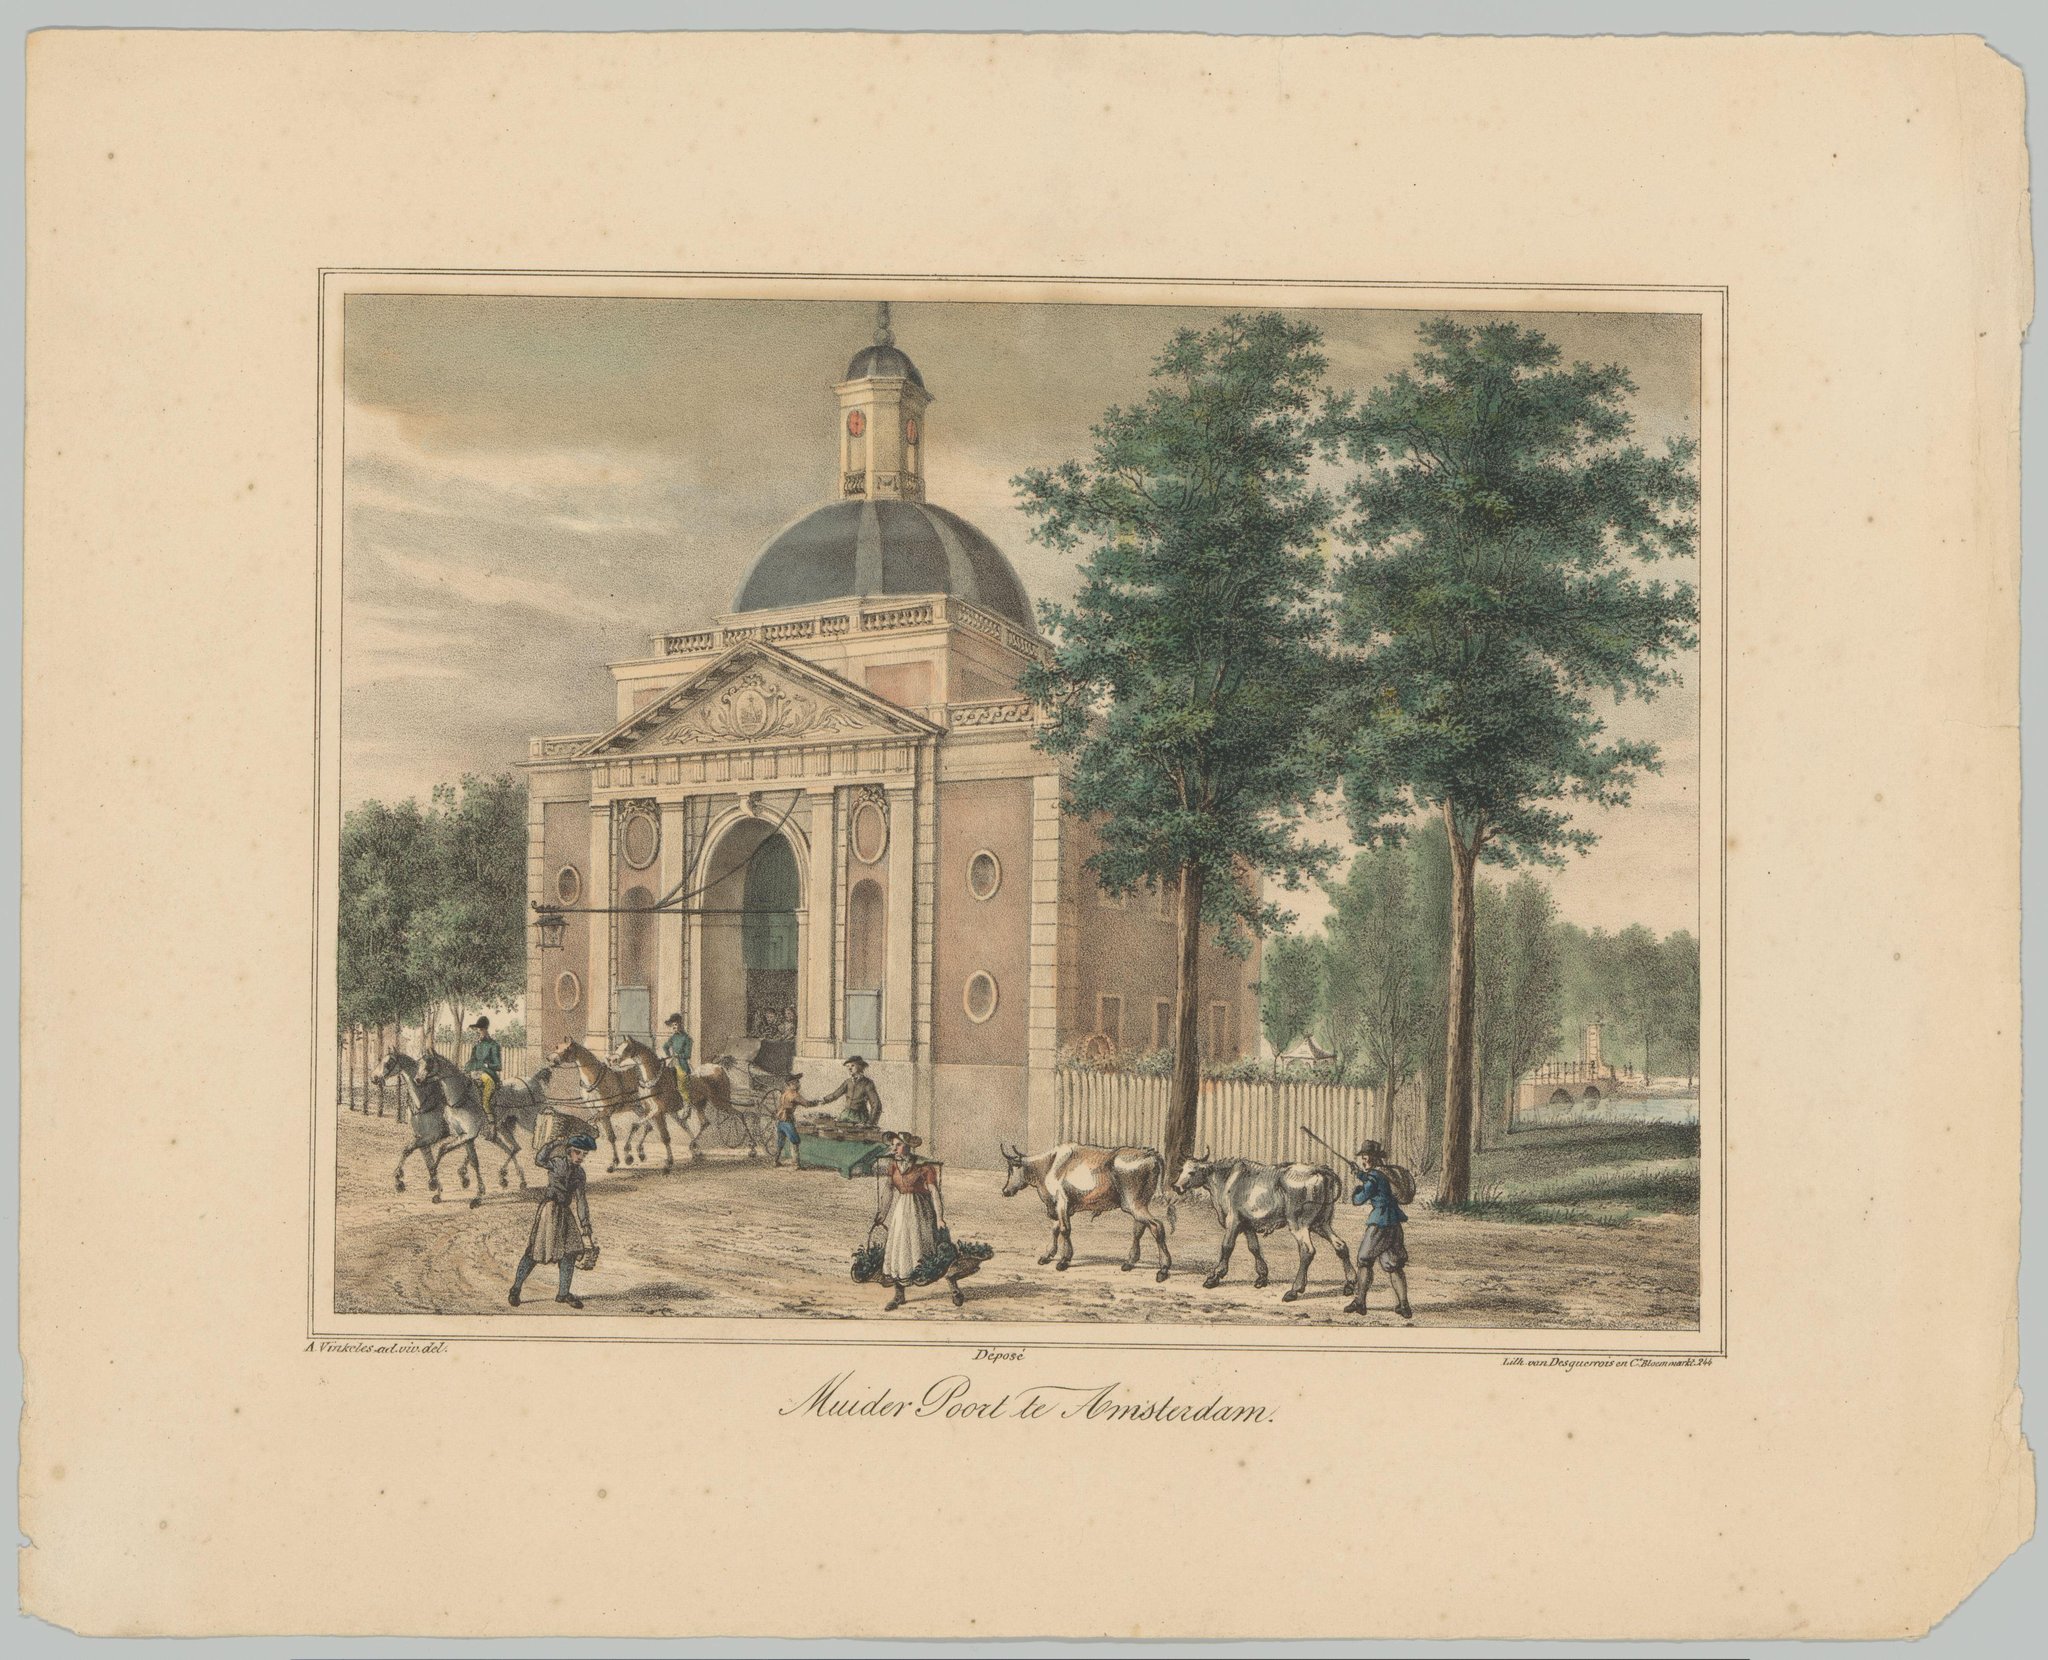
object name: print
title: Gezichten van de Zes Voornaamste Poorten der Stad Amsterdam. 1ste Cahier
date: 1828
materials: paper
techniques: hand coloring, lithograph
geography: amsterdam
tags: gate, entrance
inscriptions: collector's mark: Lugt 2228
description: Onderdeel van een omslag met een serie van zes lithografieën van Amsterdamse poorten.